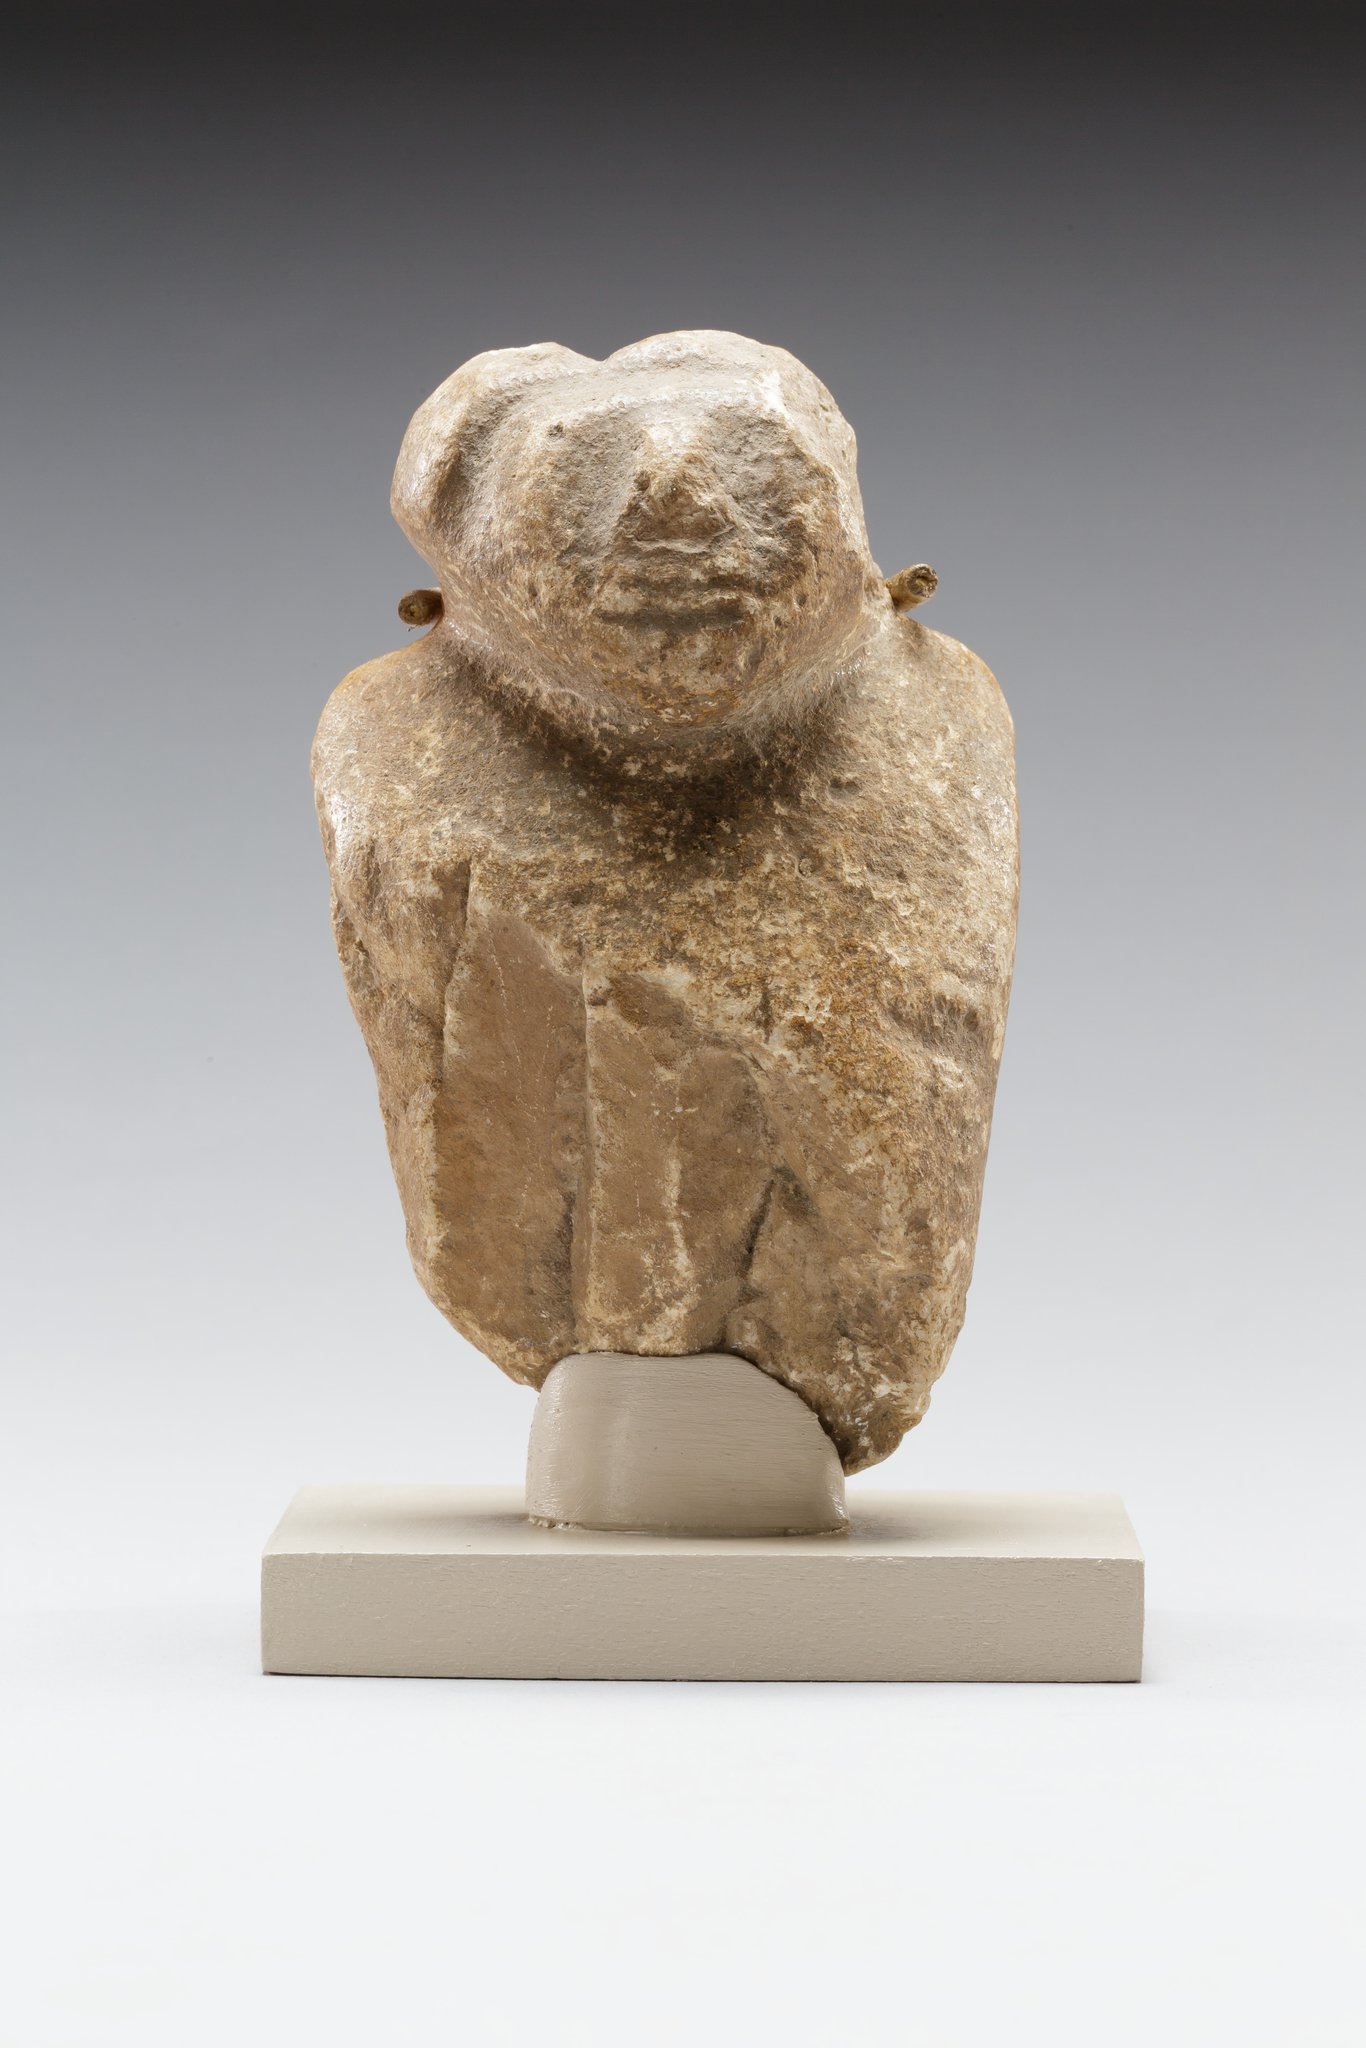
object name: figure of captive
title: Magical figure of captive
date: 1981-1650 BCE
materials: paint, stone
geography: egypt